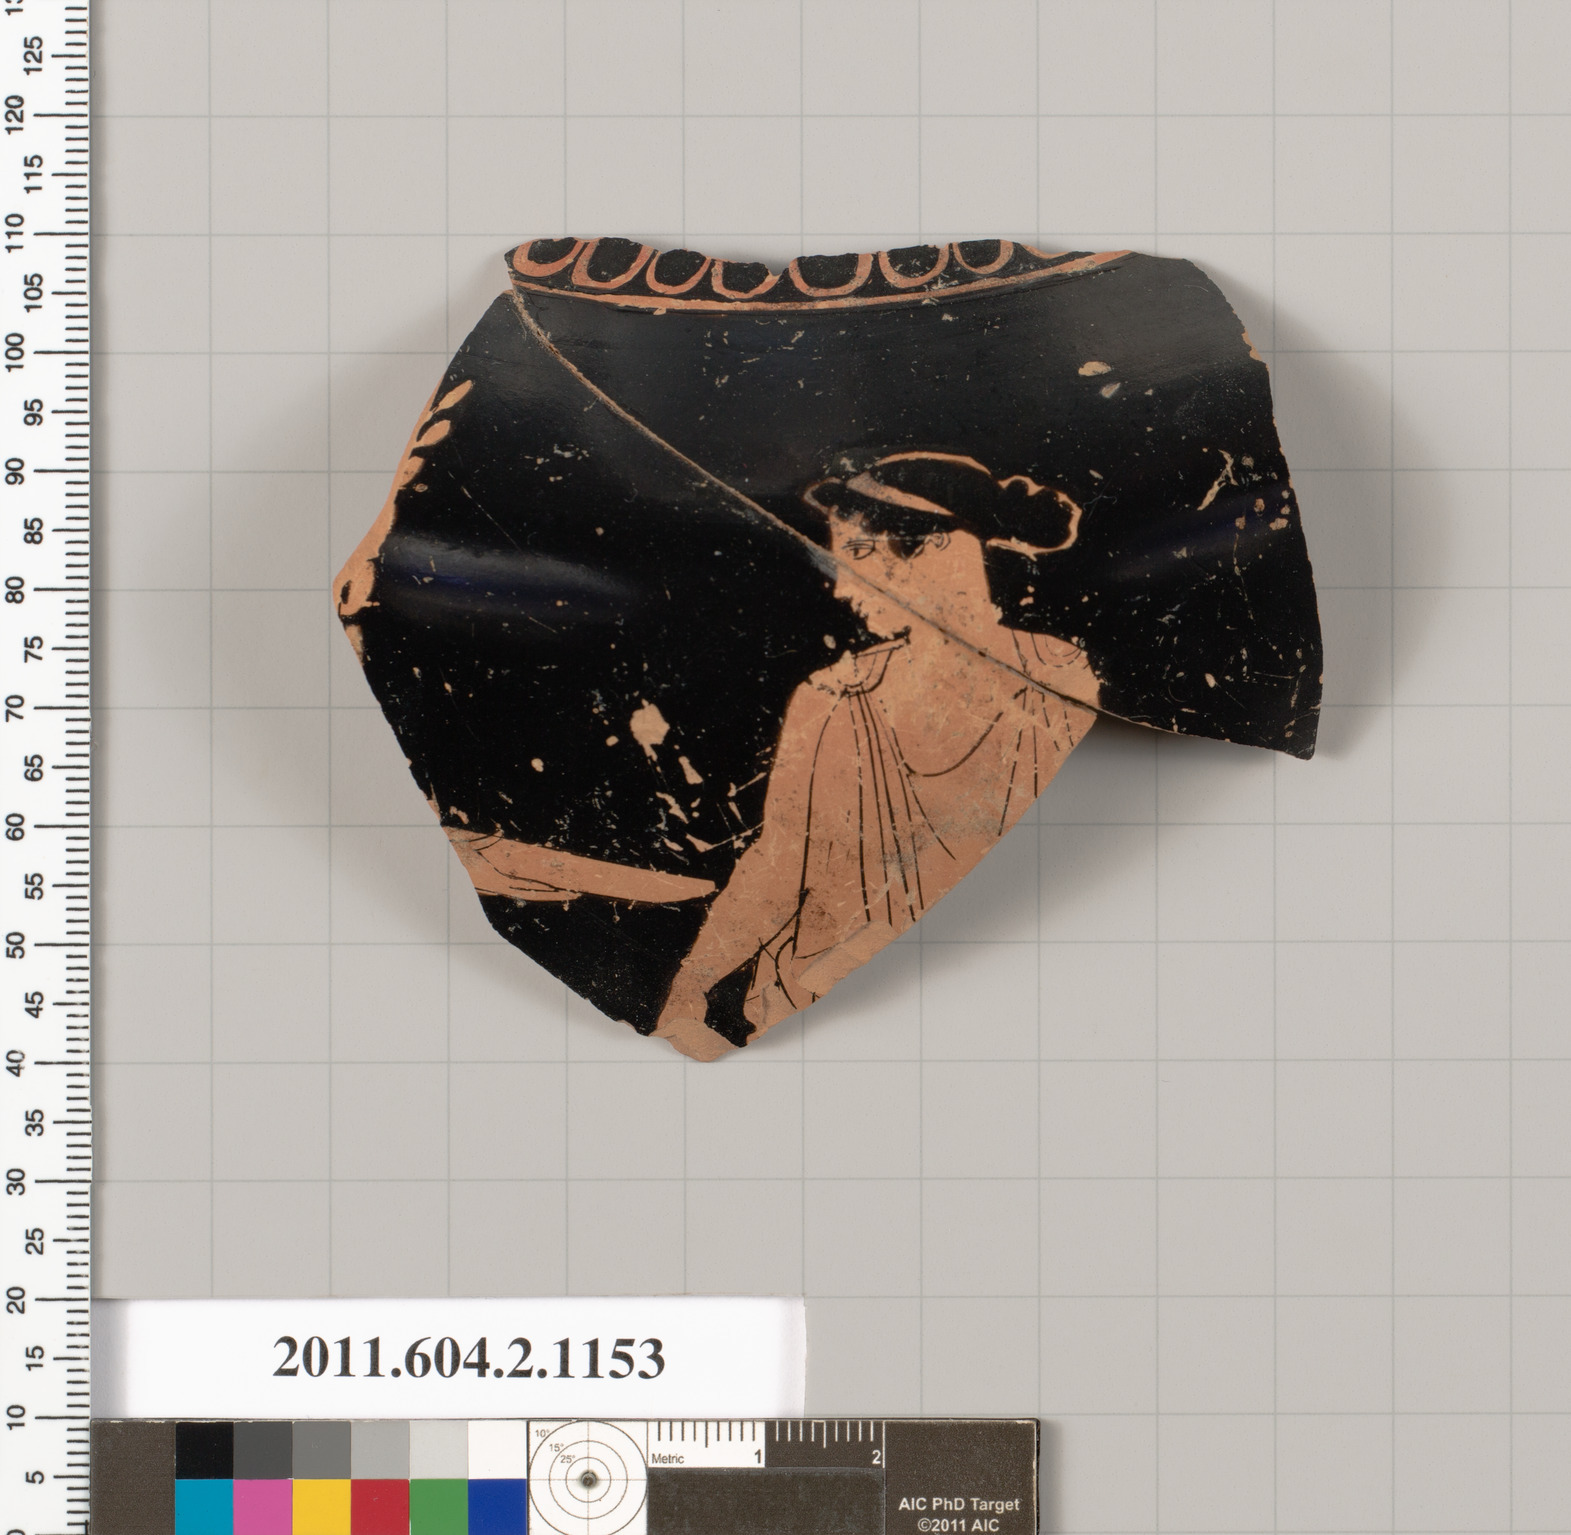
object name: oinochoe fragment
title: Terracotta fragment of an oinochoe (jug) ?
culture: greek, attic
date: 460-450 BCE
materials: terracotta